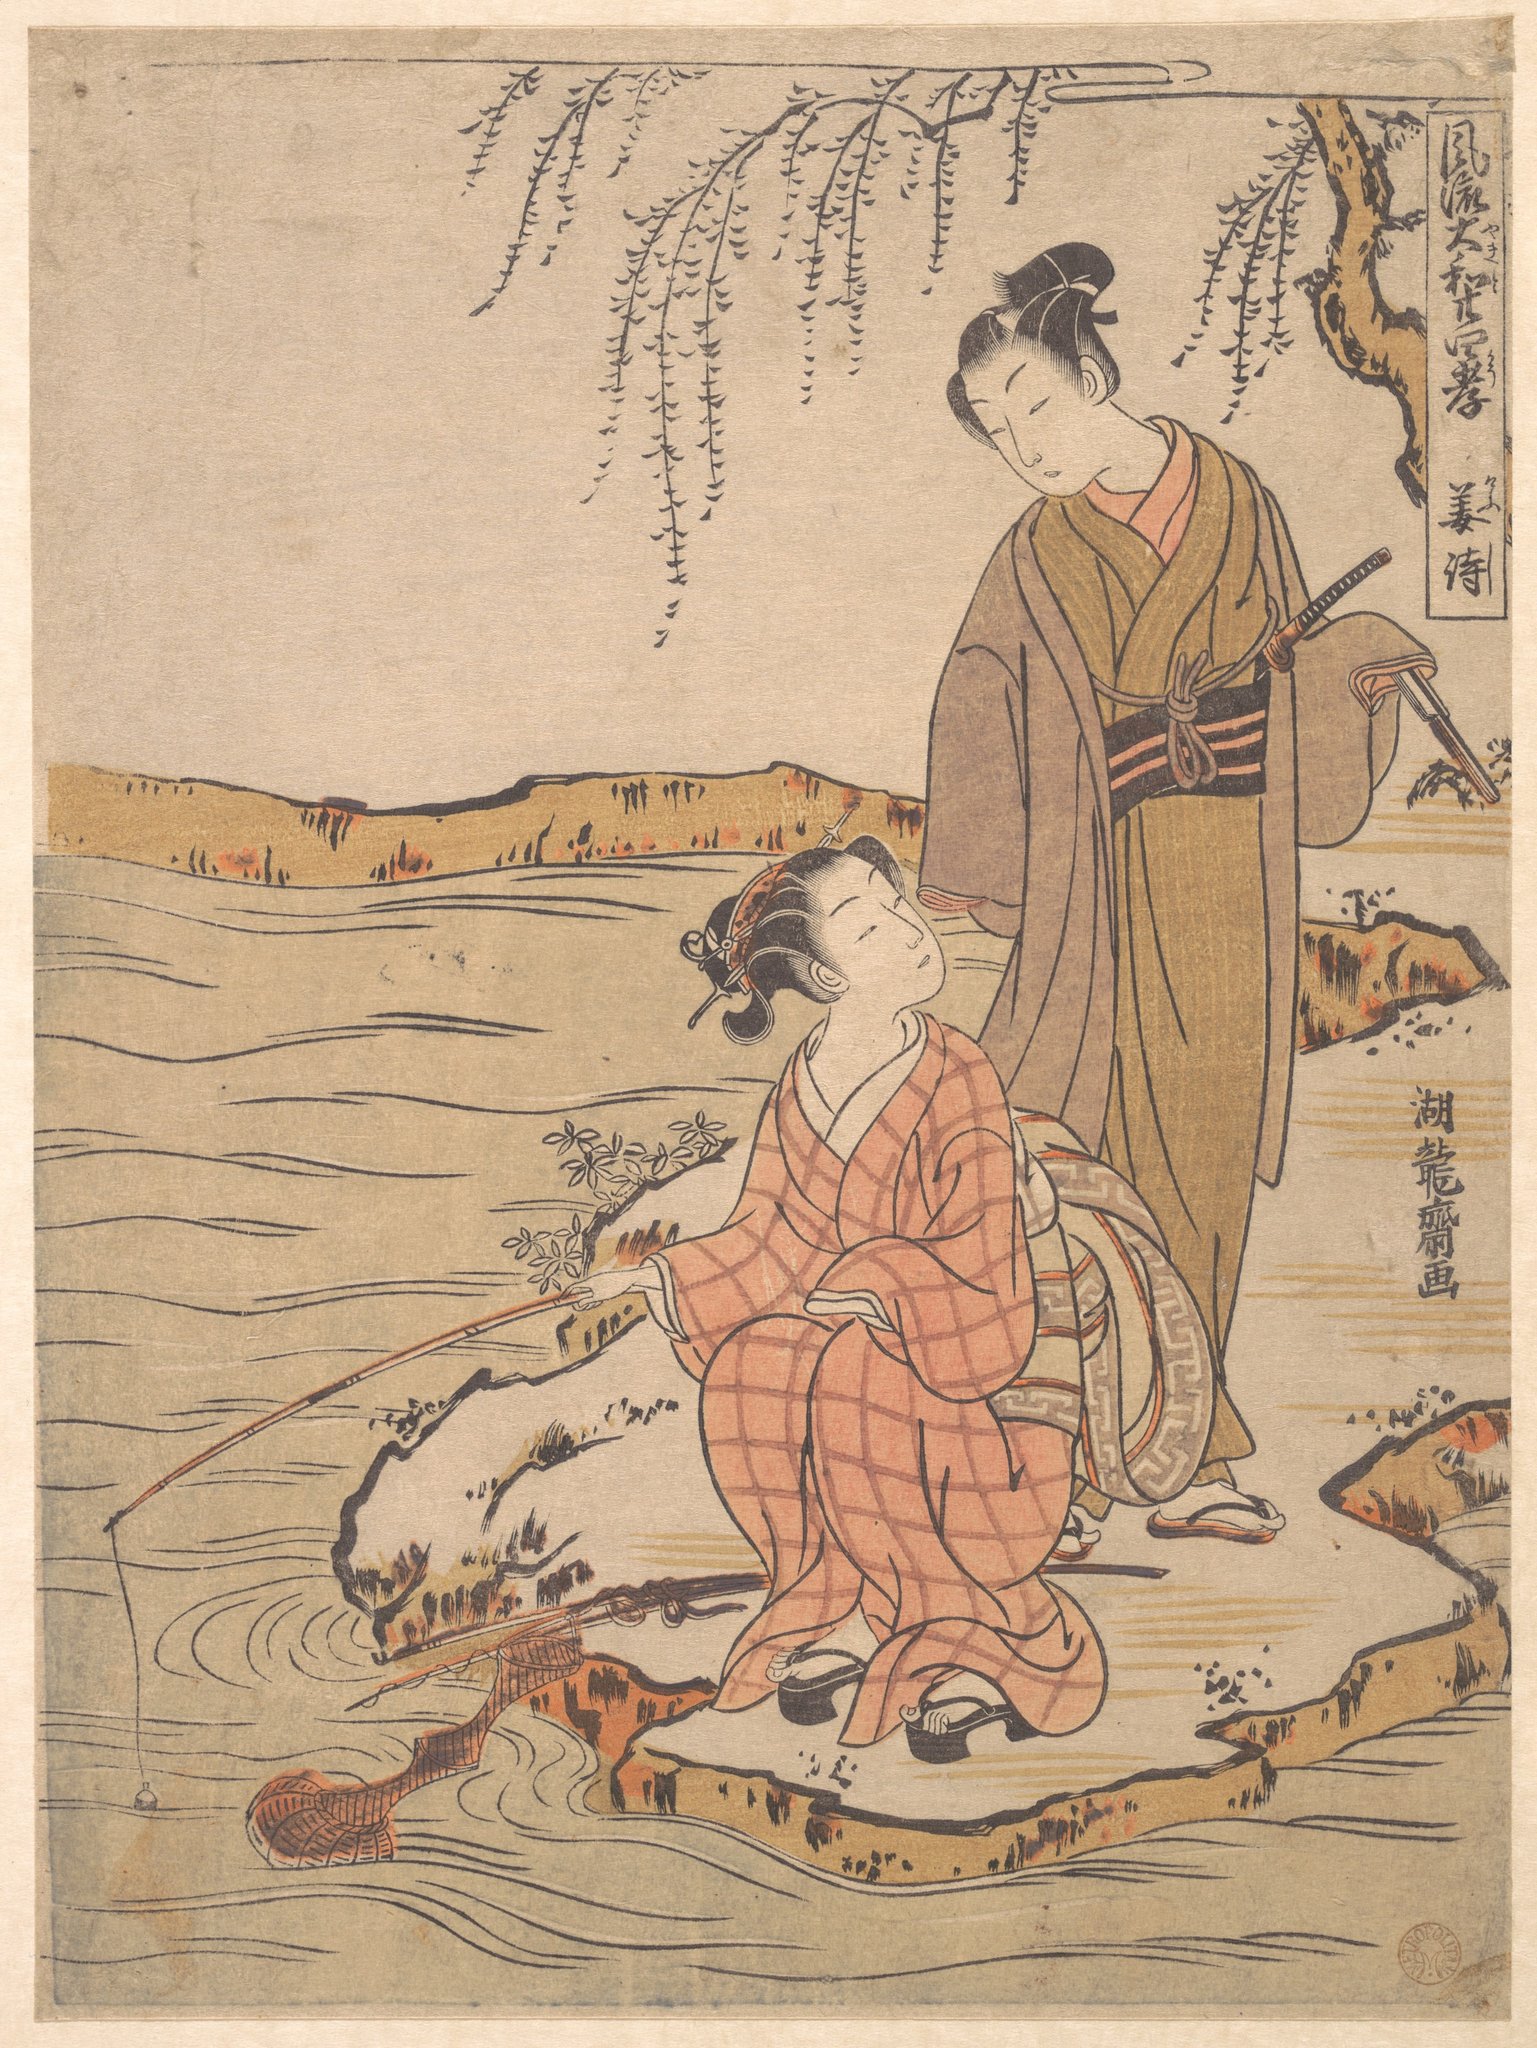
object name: print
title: Kyo Shi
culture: japanese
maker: isoda koryūsai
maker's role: artist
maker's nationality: japanese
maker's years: 1735-1790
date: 1765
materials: ink, paper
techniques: woodblock print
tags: women,fishing